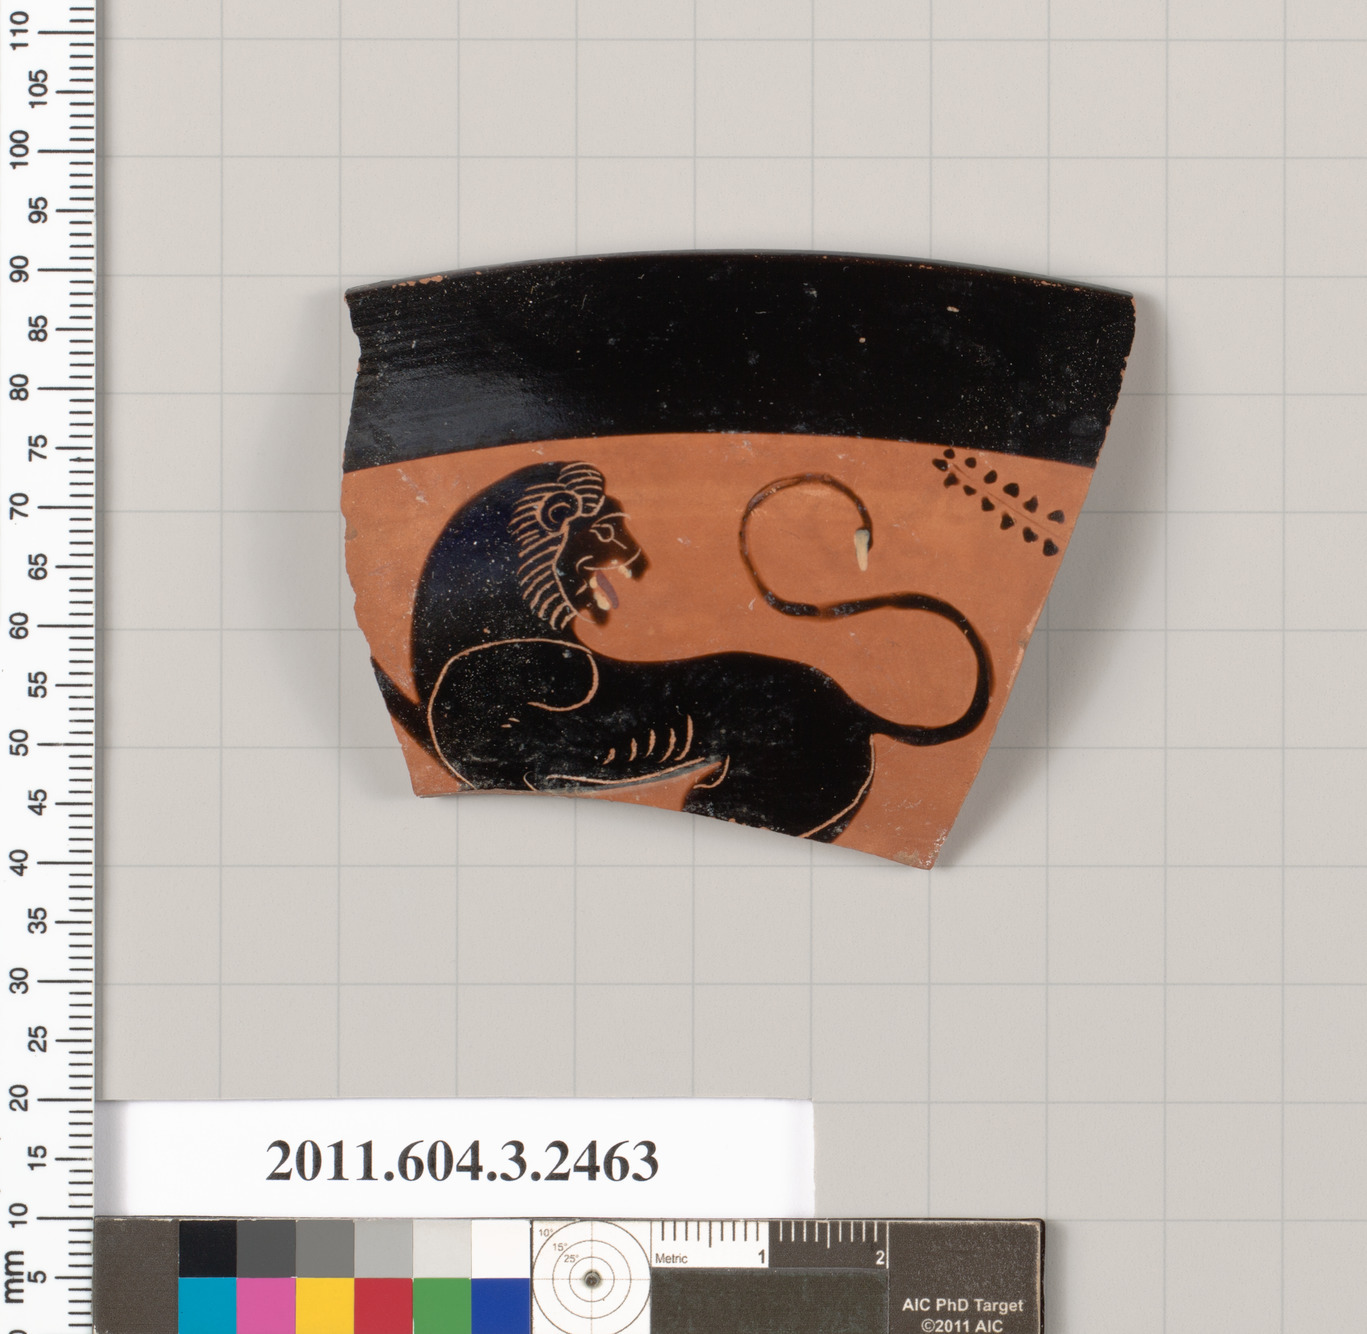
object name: kylix fragment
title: Terracotta rim fragment of a kylix (drinking cup)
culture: greek, attic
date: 525-501 BCE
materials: terracotta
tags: lions